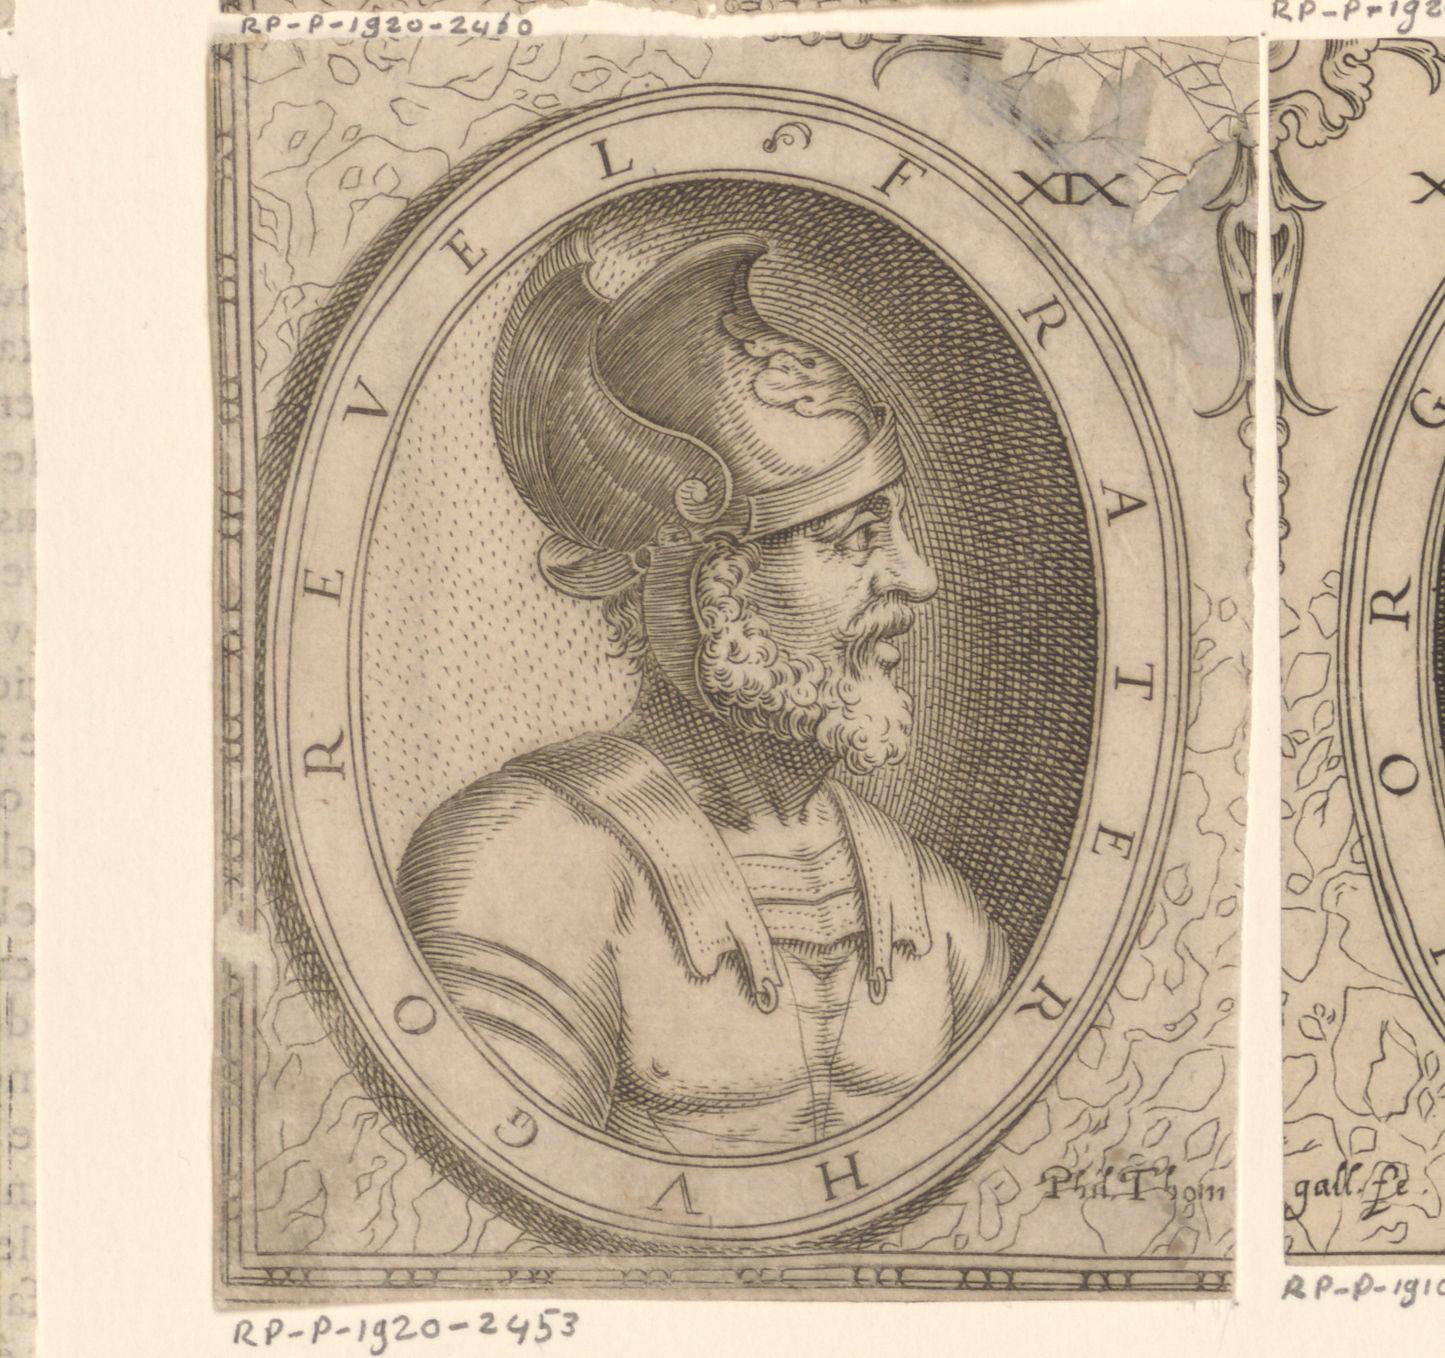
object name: print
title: Portret van Hugues de Revel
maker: philippe thomassin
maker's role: print maker, publisher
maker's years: 1562-1622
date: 1588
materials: paper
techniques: engraving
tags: historical persons, military orders, e.g.: knights templars, knights of malta, teutonic knights ~ roman catholic church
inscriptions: collector's mark: Lugt 2228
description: Deze prent maakt deel uit van een grotere prent met vier portretten die later is verknipt. Prent waarschijnlijk uit: Veltroni, Tolomeo. Statuta hospitalis Hierusalem. [Rome: s.n., 1588].